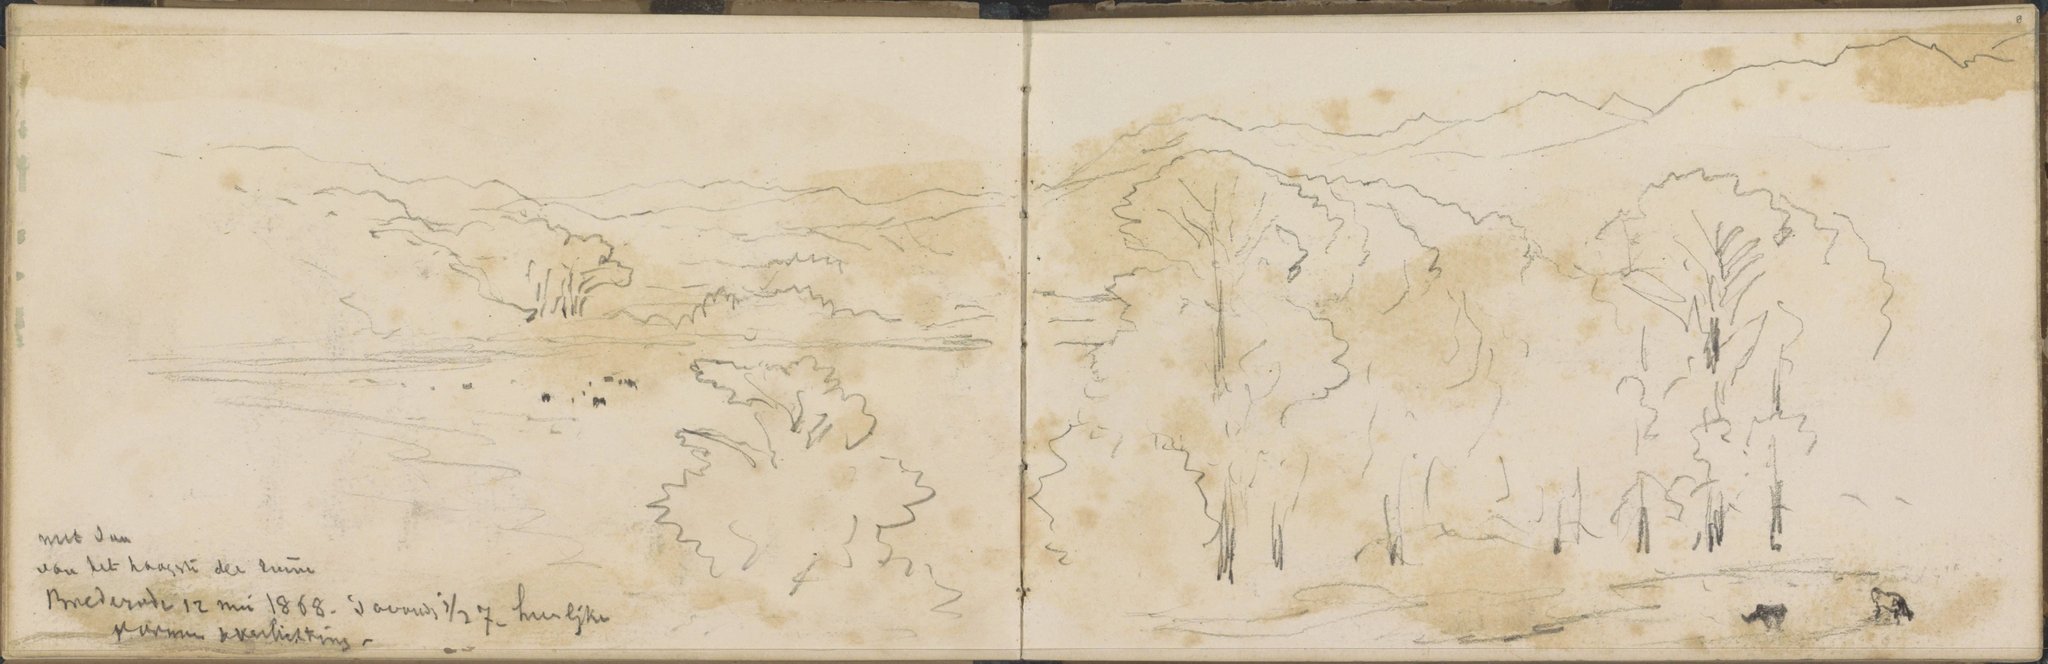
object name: sketchbook leaf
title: Uitzicht vanaf de Ruïne van Brederode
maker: johannes tavenraat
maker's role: draughtsman, painter, print maker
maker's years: 1809-1881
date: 1805-1868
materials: paper, pencil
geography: santpoort-zuid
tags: trees, cattle, santpoort-zuid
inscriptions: date and inscription: ‘met Jan/ van het hoogste der ruine/ Brederode 12 mei 1868. 's avonds 1/2 7 heerlijke/ warmen [...]verlichting.’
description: Landschap met voornamelijk bos en grazend vee. Blad 7 verso en 8 recto uit een schetsboek met 48 bladen.